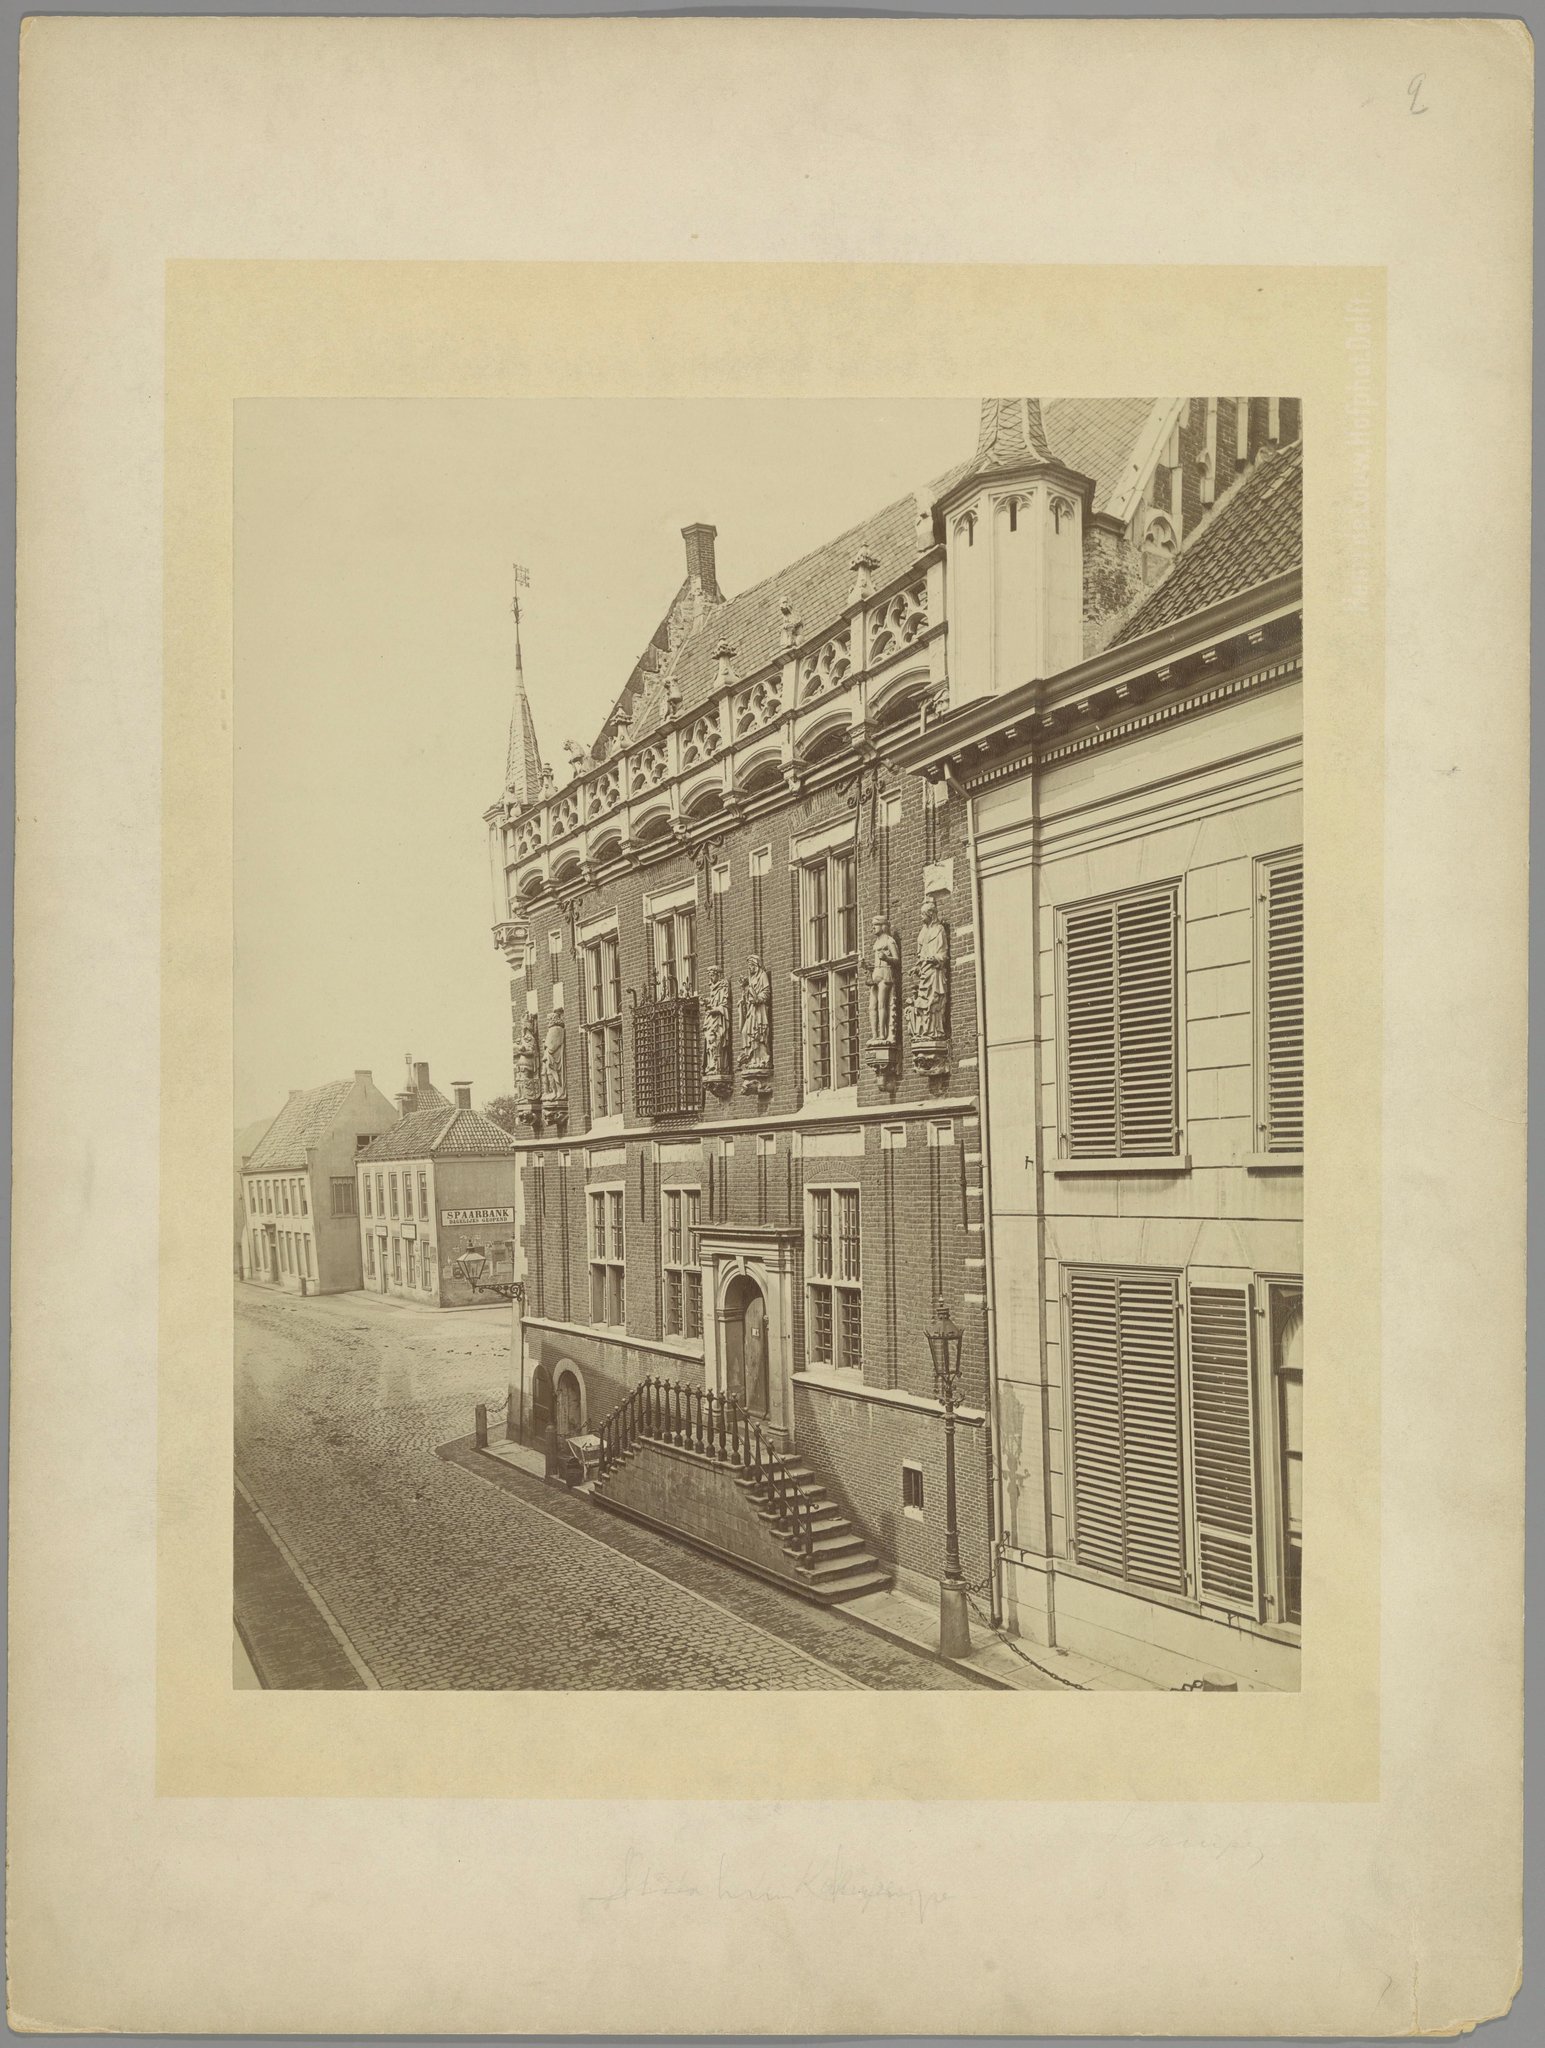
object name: photograph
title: Stadhuis Kampen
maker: Anonymous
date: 1875-1900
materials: cardboard, photographic support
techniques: albumen print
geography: kampen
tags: advertising, townhall, piece of sculpture, reproduction of a piece of sculpture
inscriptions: collector's mark: Lugt 3937